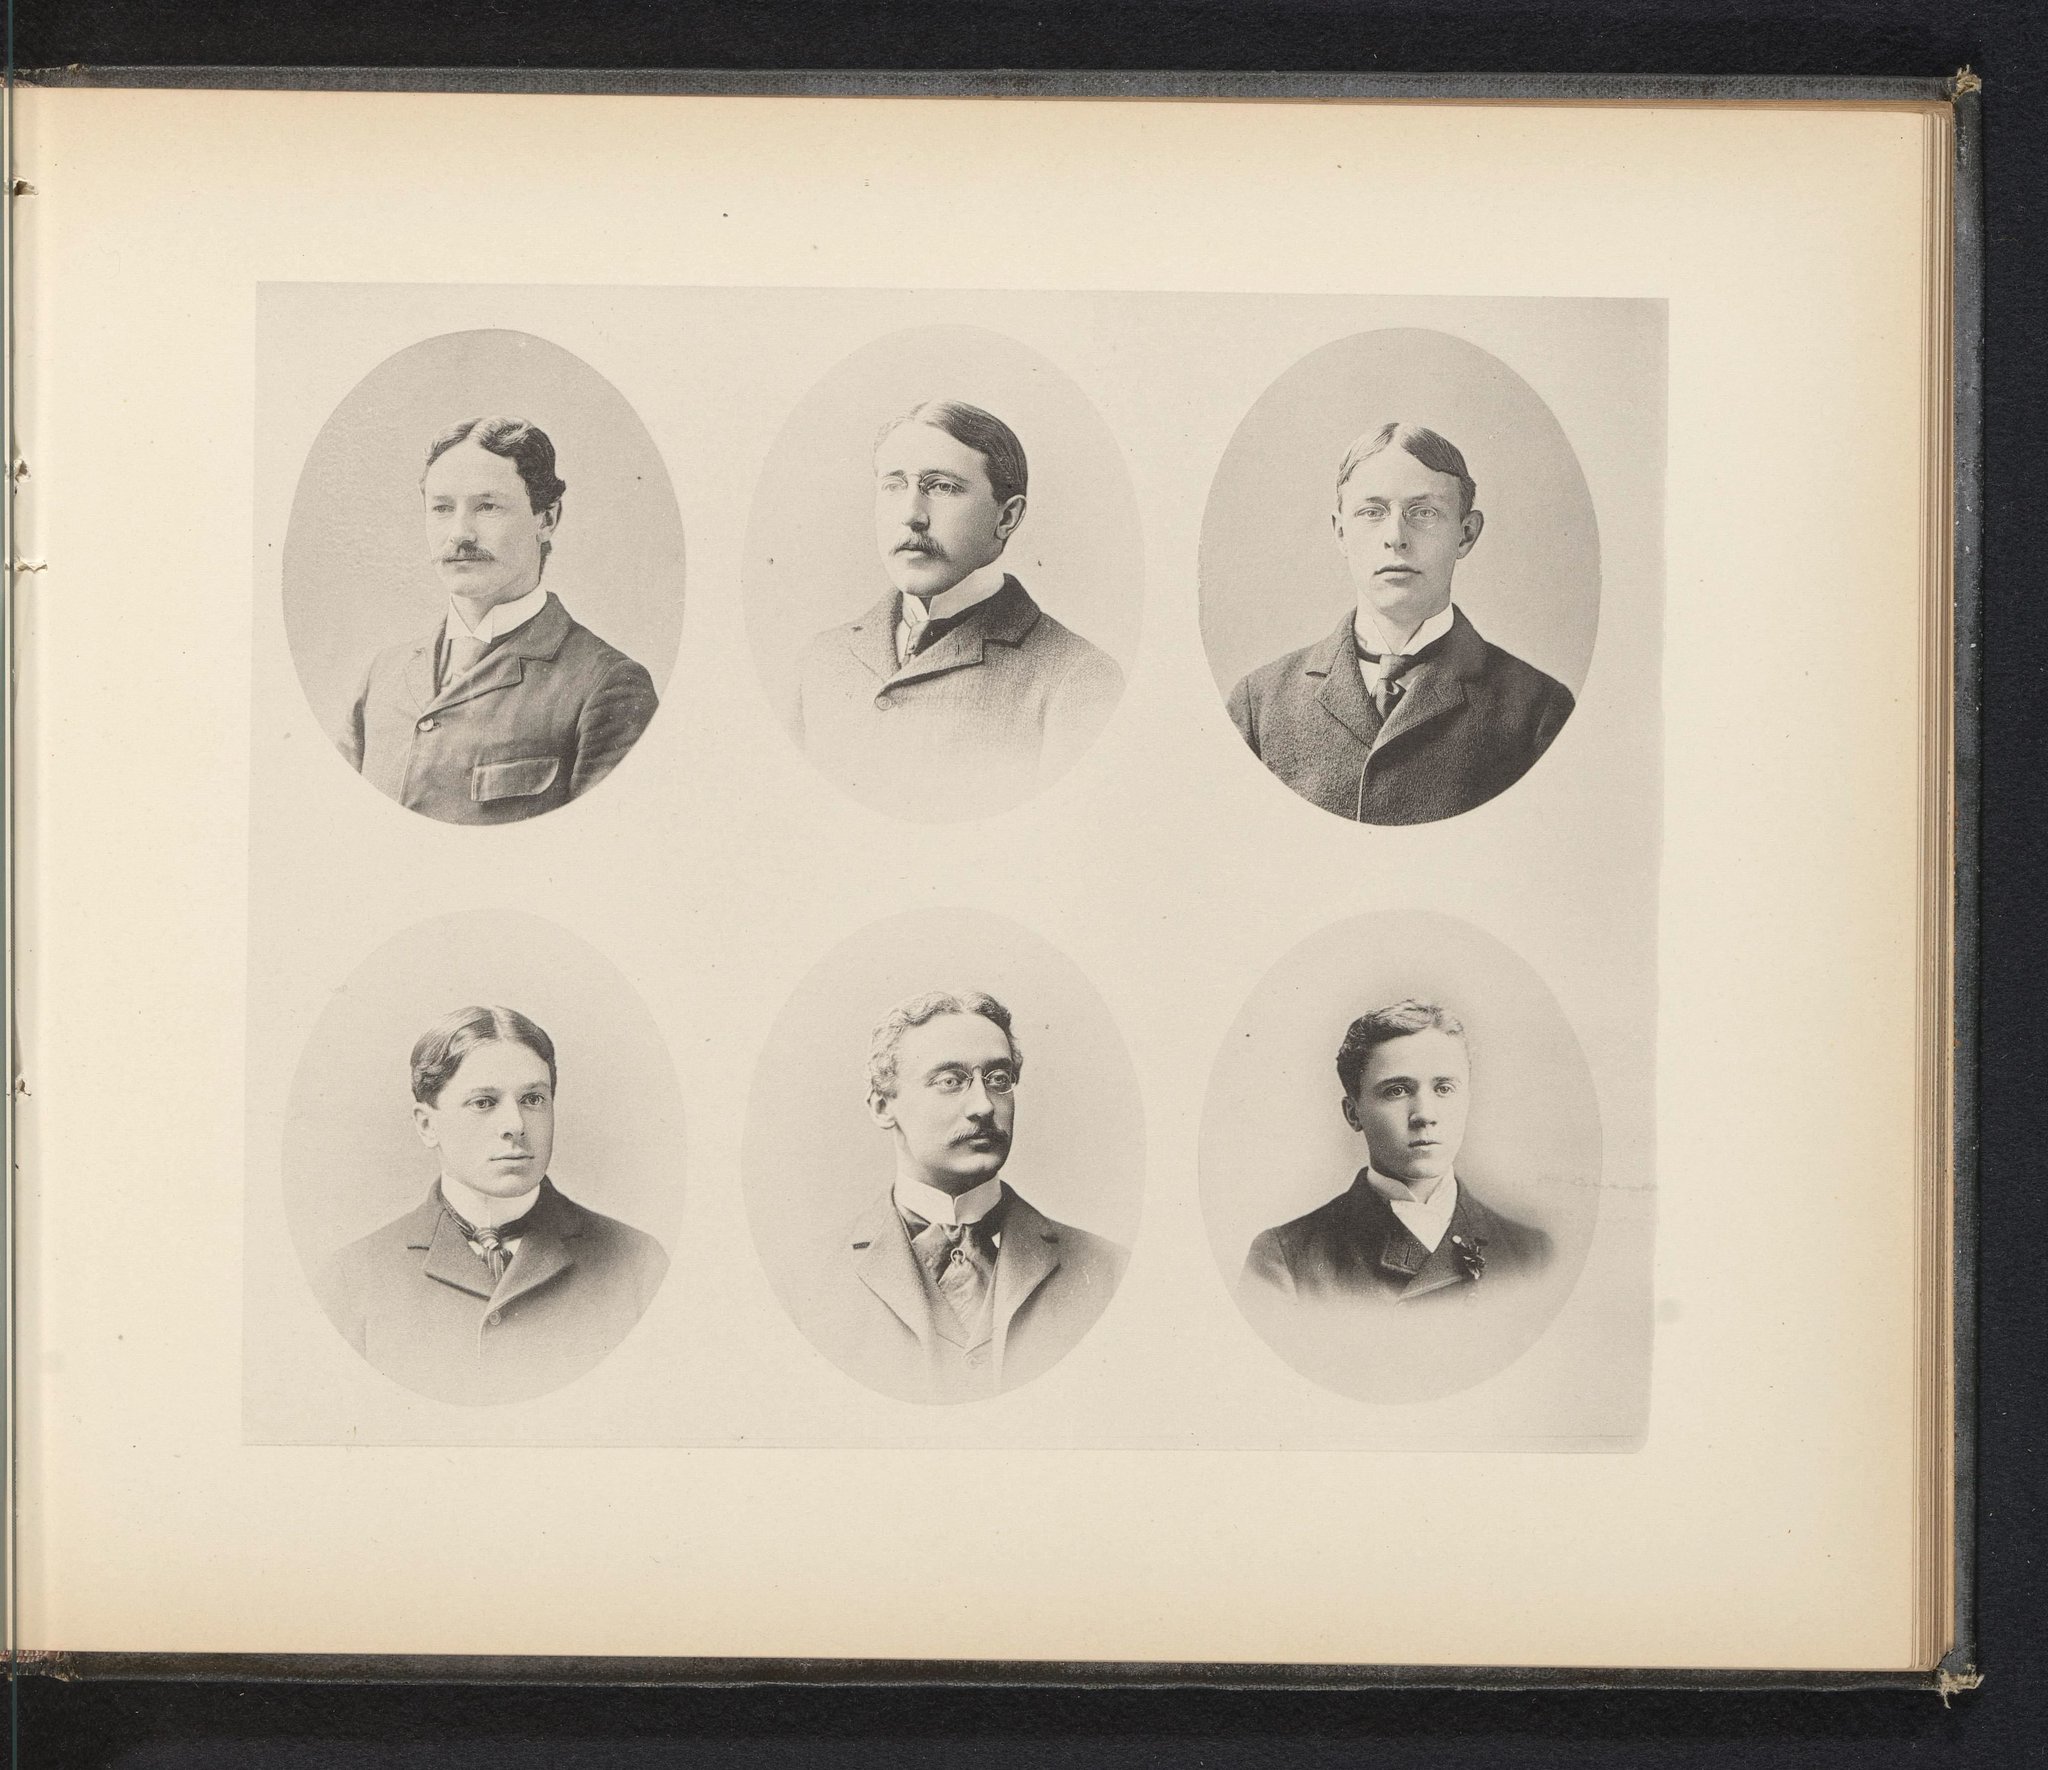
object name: photomechanical print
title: Zes portretten van afgestudeerde studenten van Yale University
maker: Anonymous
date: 1895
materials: paper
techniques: photograph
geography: new york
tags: student